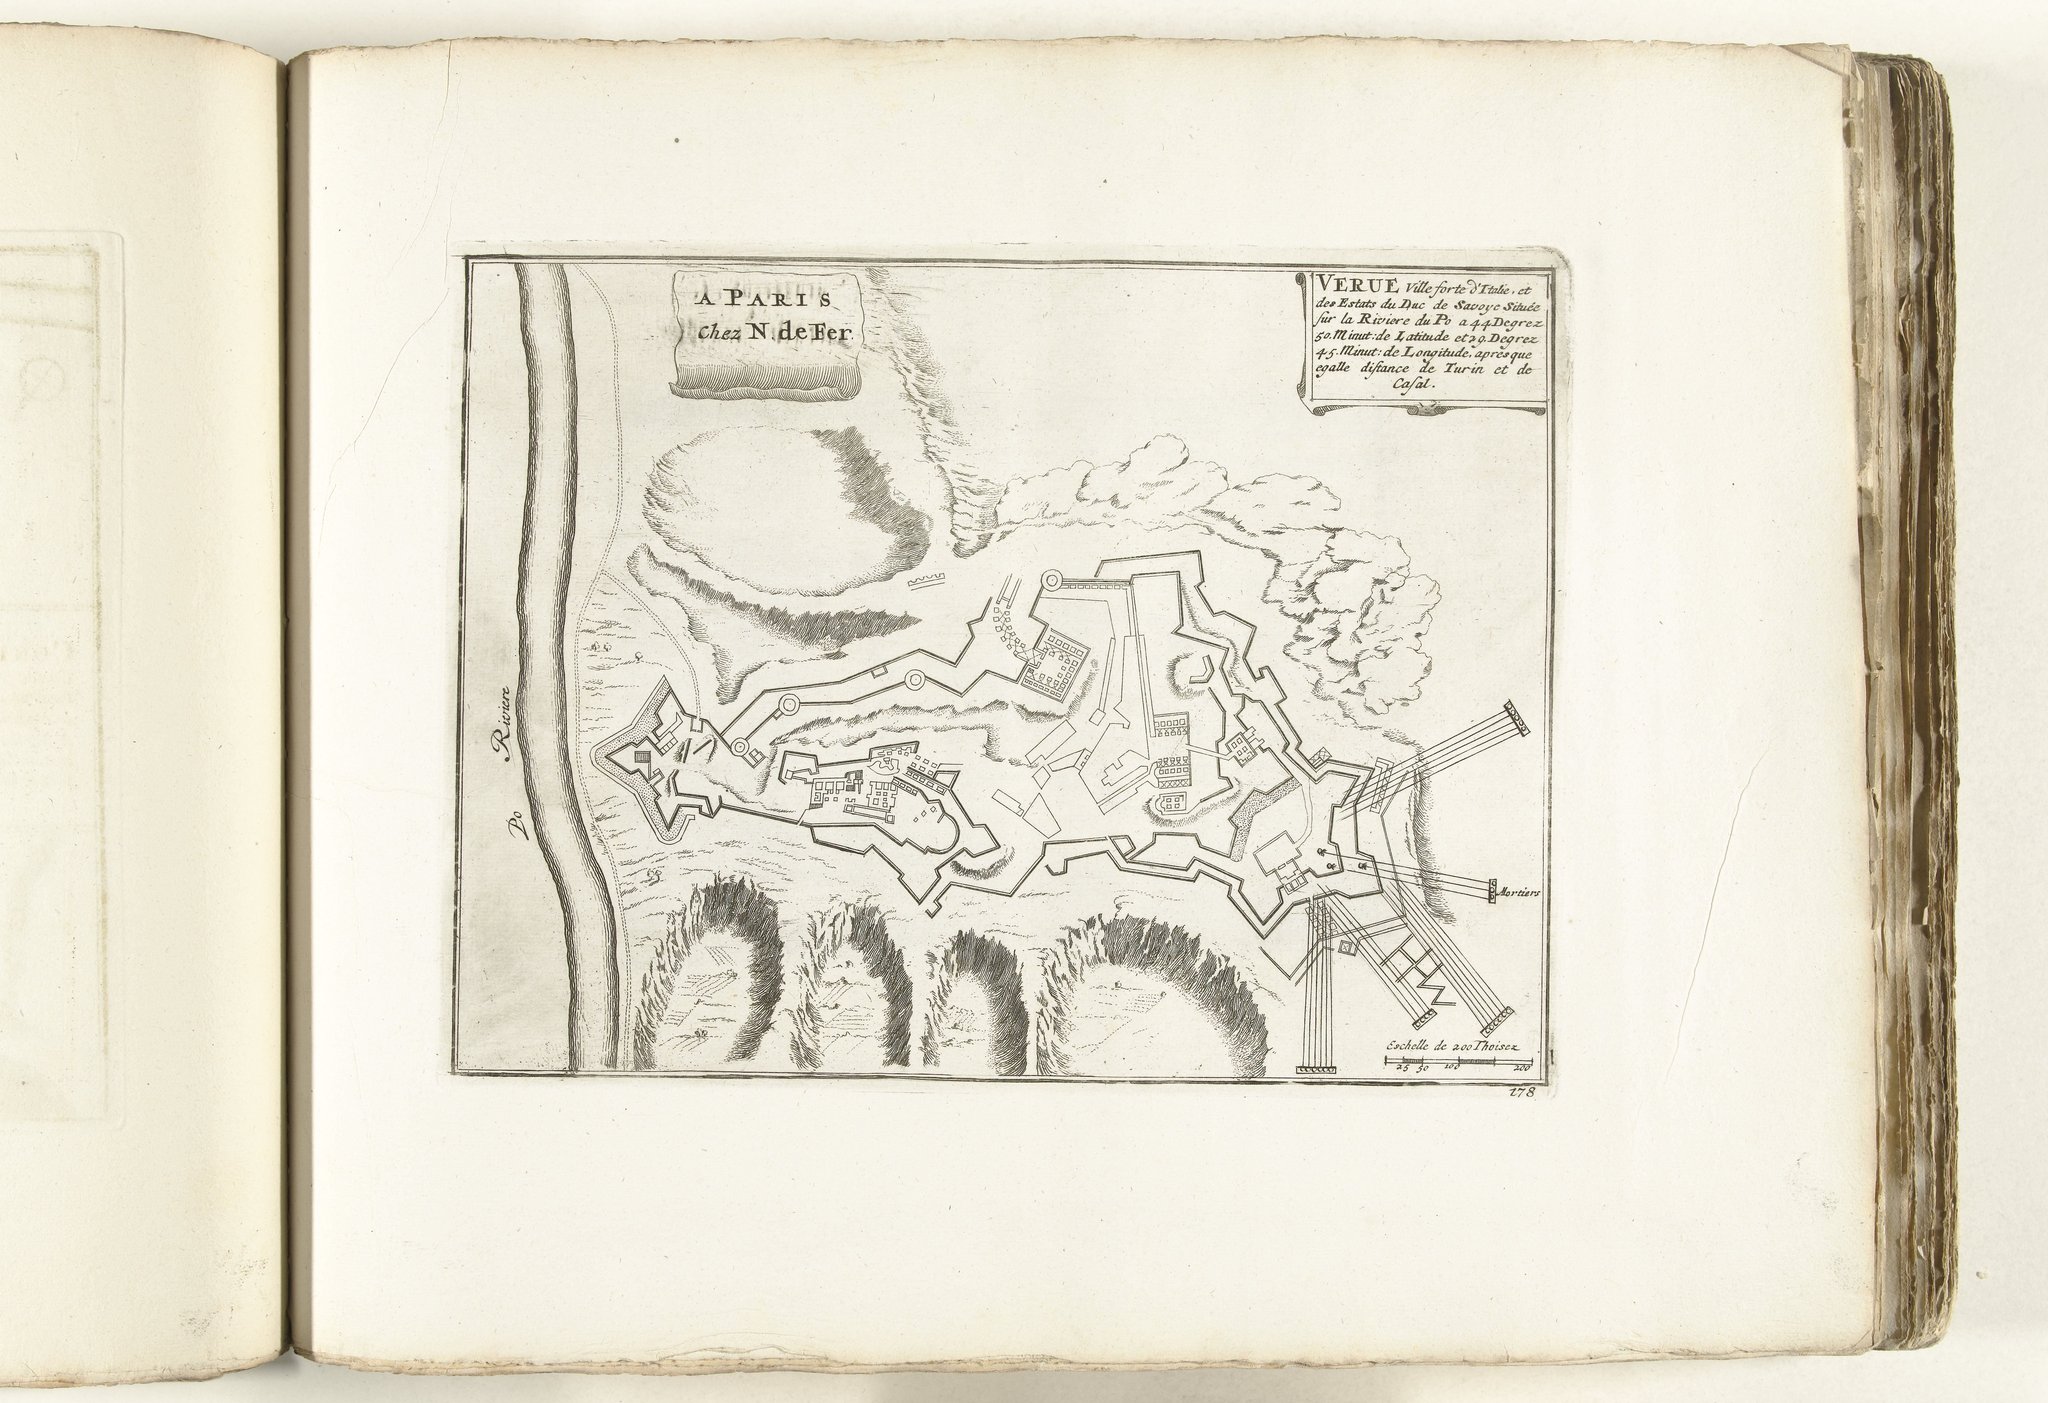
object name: map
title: Les Forces de l'Europe, Asie, Afrique et Amerique, ou description des principales villes avec leurs fortifications. Dessignées par les meilleurs ingenieurs, particulierement celles qui sont sous la domination de la France (...) et ornées de plusieurs superbes edifices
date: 1702-1703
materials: paper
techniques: etching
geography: paris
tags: fortress, maps of cities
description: Plattegrond van de versterkingen rond de stad Verua (Verue) aan de Po in Piemonte. Plaat nr. 178 in het prentwerk bestaande in totaal uit 276 genummerde platen van vermaarde sterke steden en vestingen in het kader van de Spaanse Successieoorlog. Voor het merendeel zijn deze platen gekopieerd naar de anonieme Franse platen: in Les forces de l'Europe en in: Le theatre de la guerre, dans les Pays-Bas, beide oorspronkelijk uitgegeven door Nicolas de Fer te Parijs (1693-1697) in het kader van de Negenjarige Oorlog. Titel en opschriften in de plaat in het Frans.